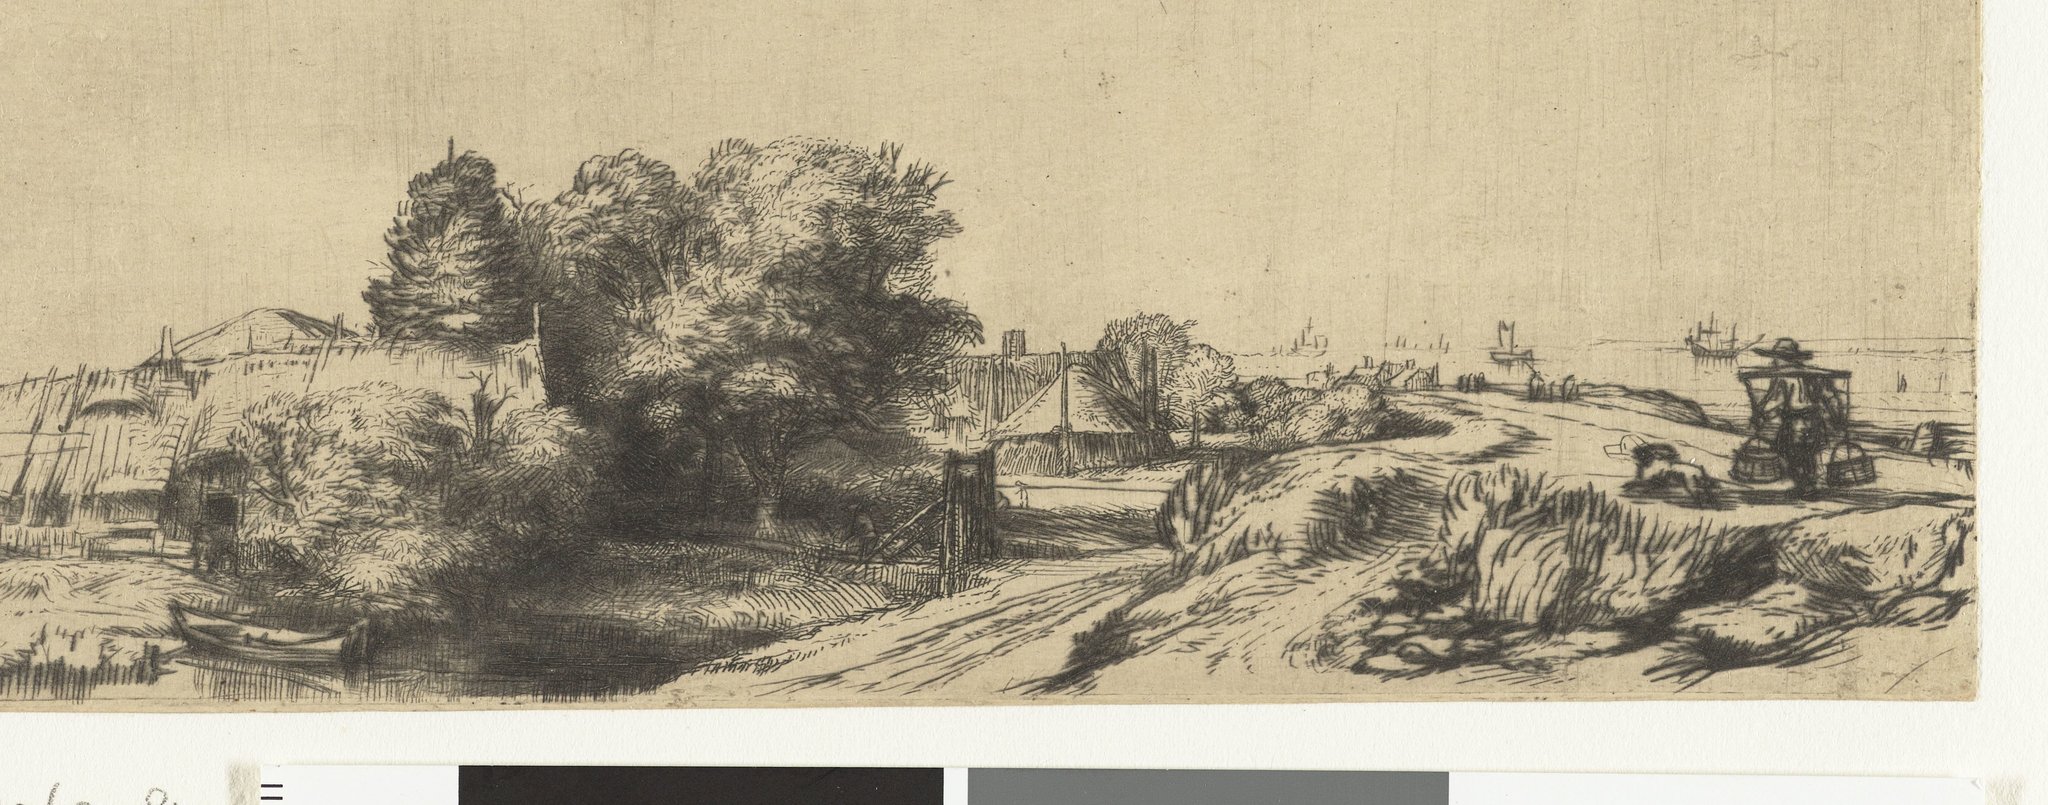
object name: print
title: View of the Diemerdijk with a milkman and cottages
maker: rembrandt van rijn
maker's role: draughtsman, painter, print maker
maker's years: 1606-1669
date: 1650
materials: paper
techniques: drypoint, etching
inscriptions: inscription: ‘C. 13263’, mark: Lugt 2228, inscription: ‘C. 1389-7500’